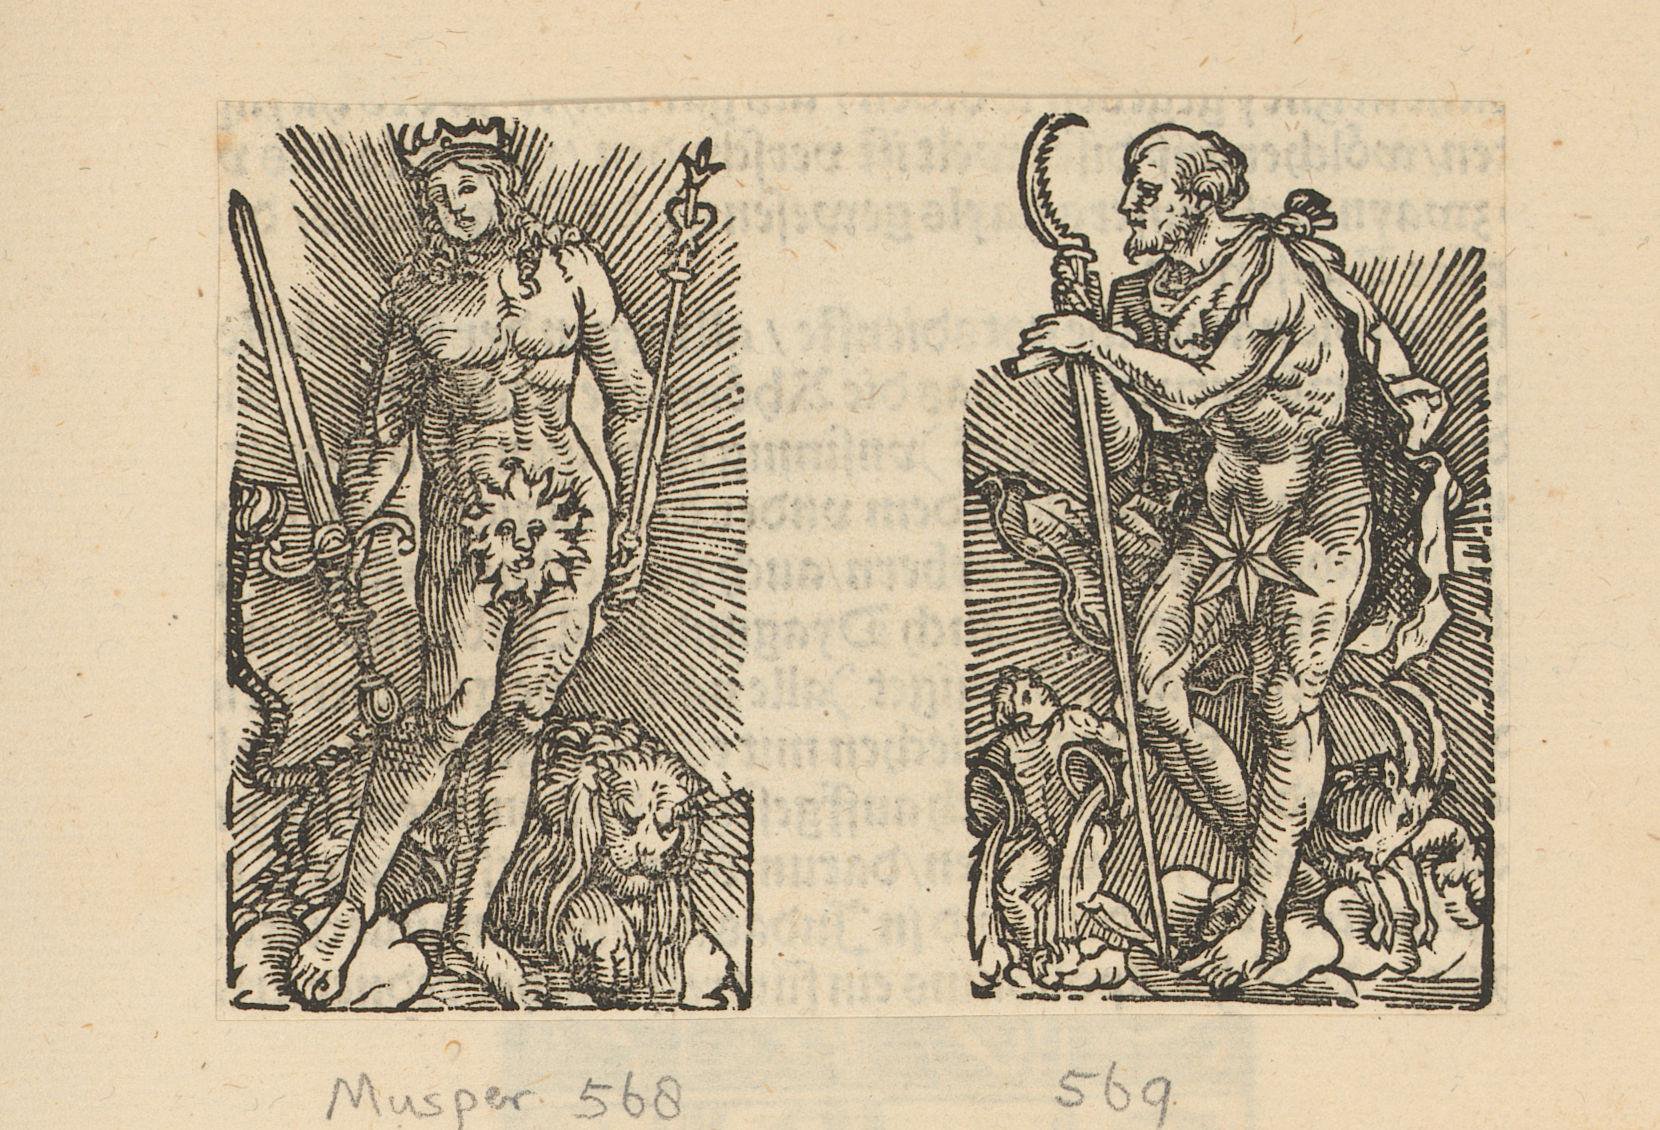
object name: album leaf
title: Personificatie van de zon (Apollo) en Saturnus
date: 1514-1531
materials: paper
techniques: letterpress printing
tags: apollo as sun-god, i.e. sol (helius), titan, saturn (planet)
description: Deze prent is gebruikt in: Cicero, Marcus Tulius. Officia M.T.C. Ein Buch so Marcus Tullius Cicero der Römer zu seynem (...). [Vertaald uit het Latijn door] Johann von Schwarzenberg. Augsburg: Heinrich Steiner, 1531.